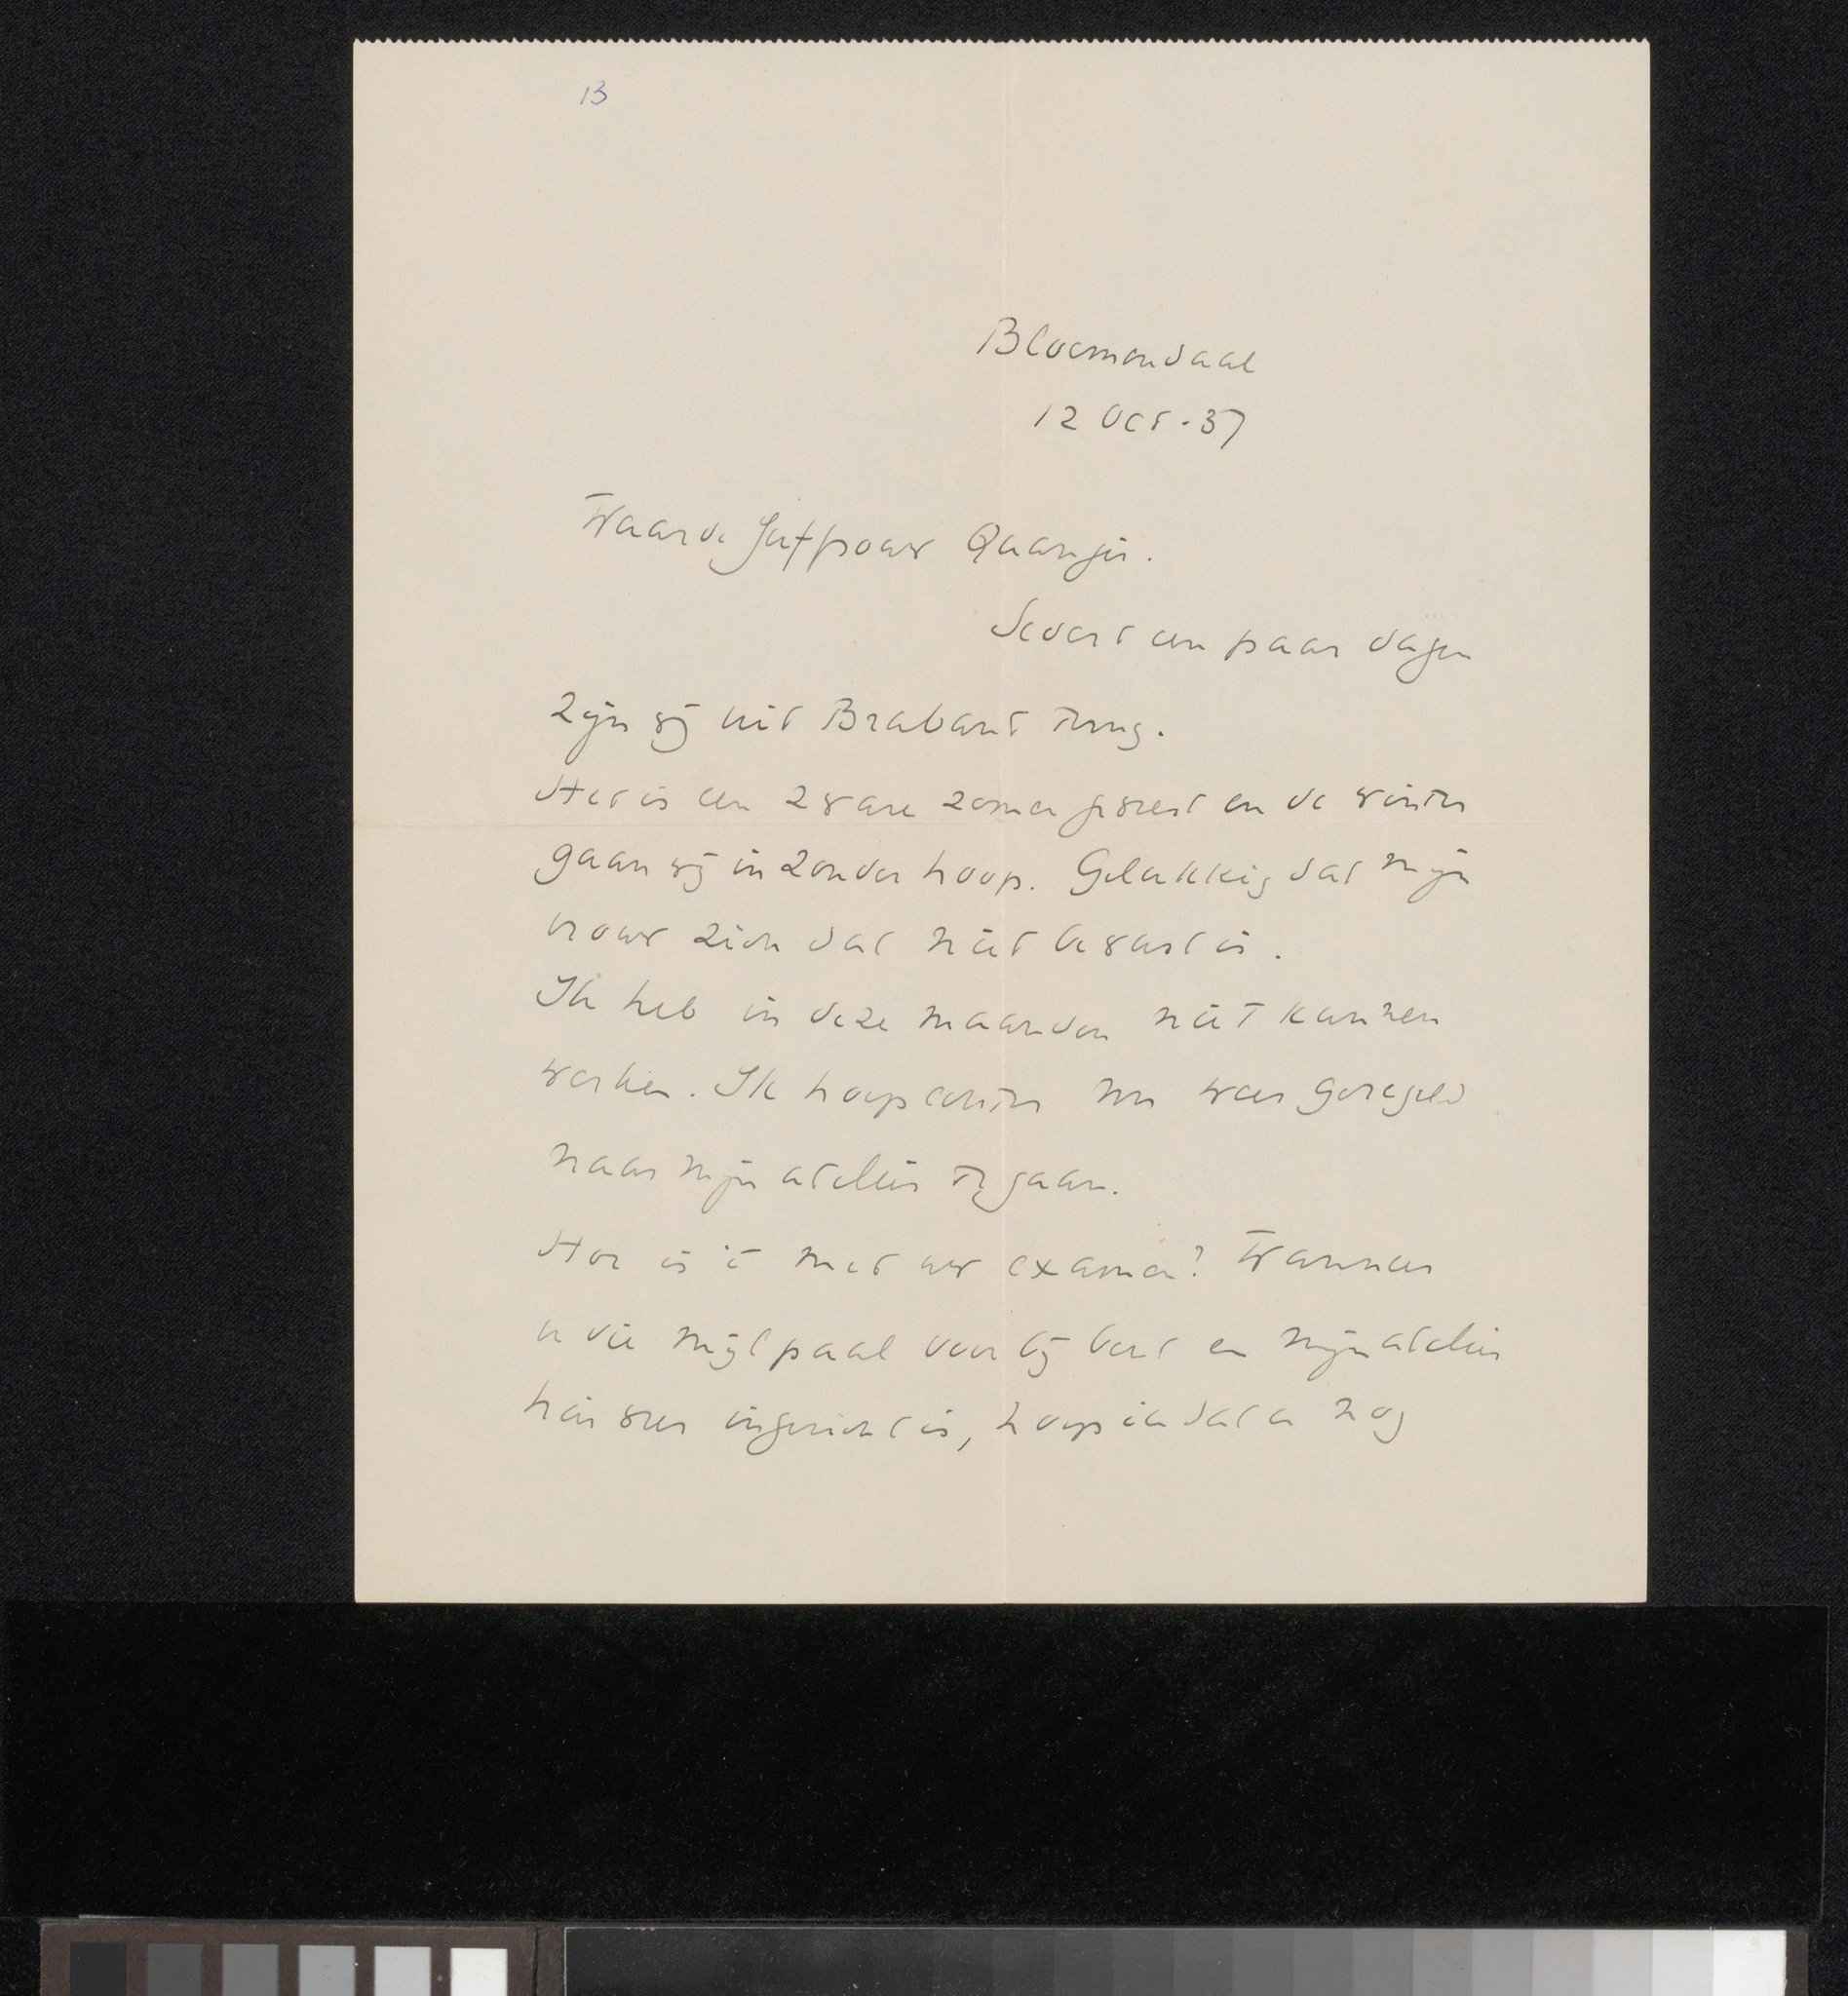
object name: letter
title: Brief aan Marisa Quanjer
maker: richard nicolaüs roland holst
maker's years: 1868-1938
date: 1937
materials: ink, paper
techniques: pen, writing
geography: bloemendaal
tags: workshop, studio of the artist (in general), brabant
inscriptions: collector's mark: ‘RPK’